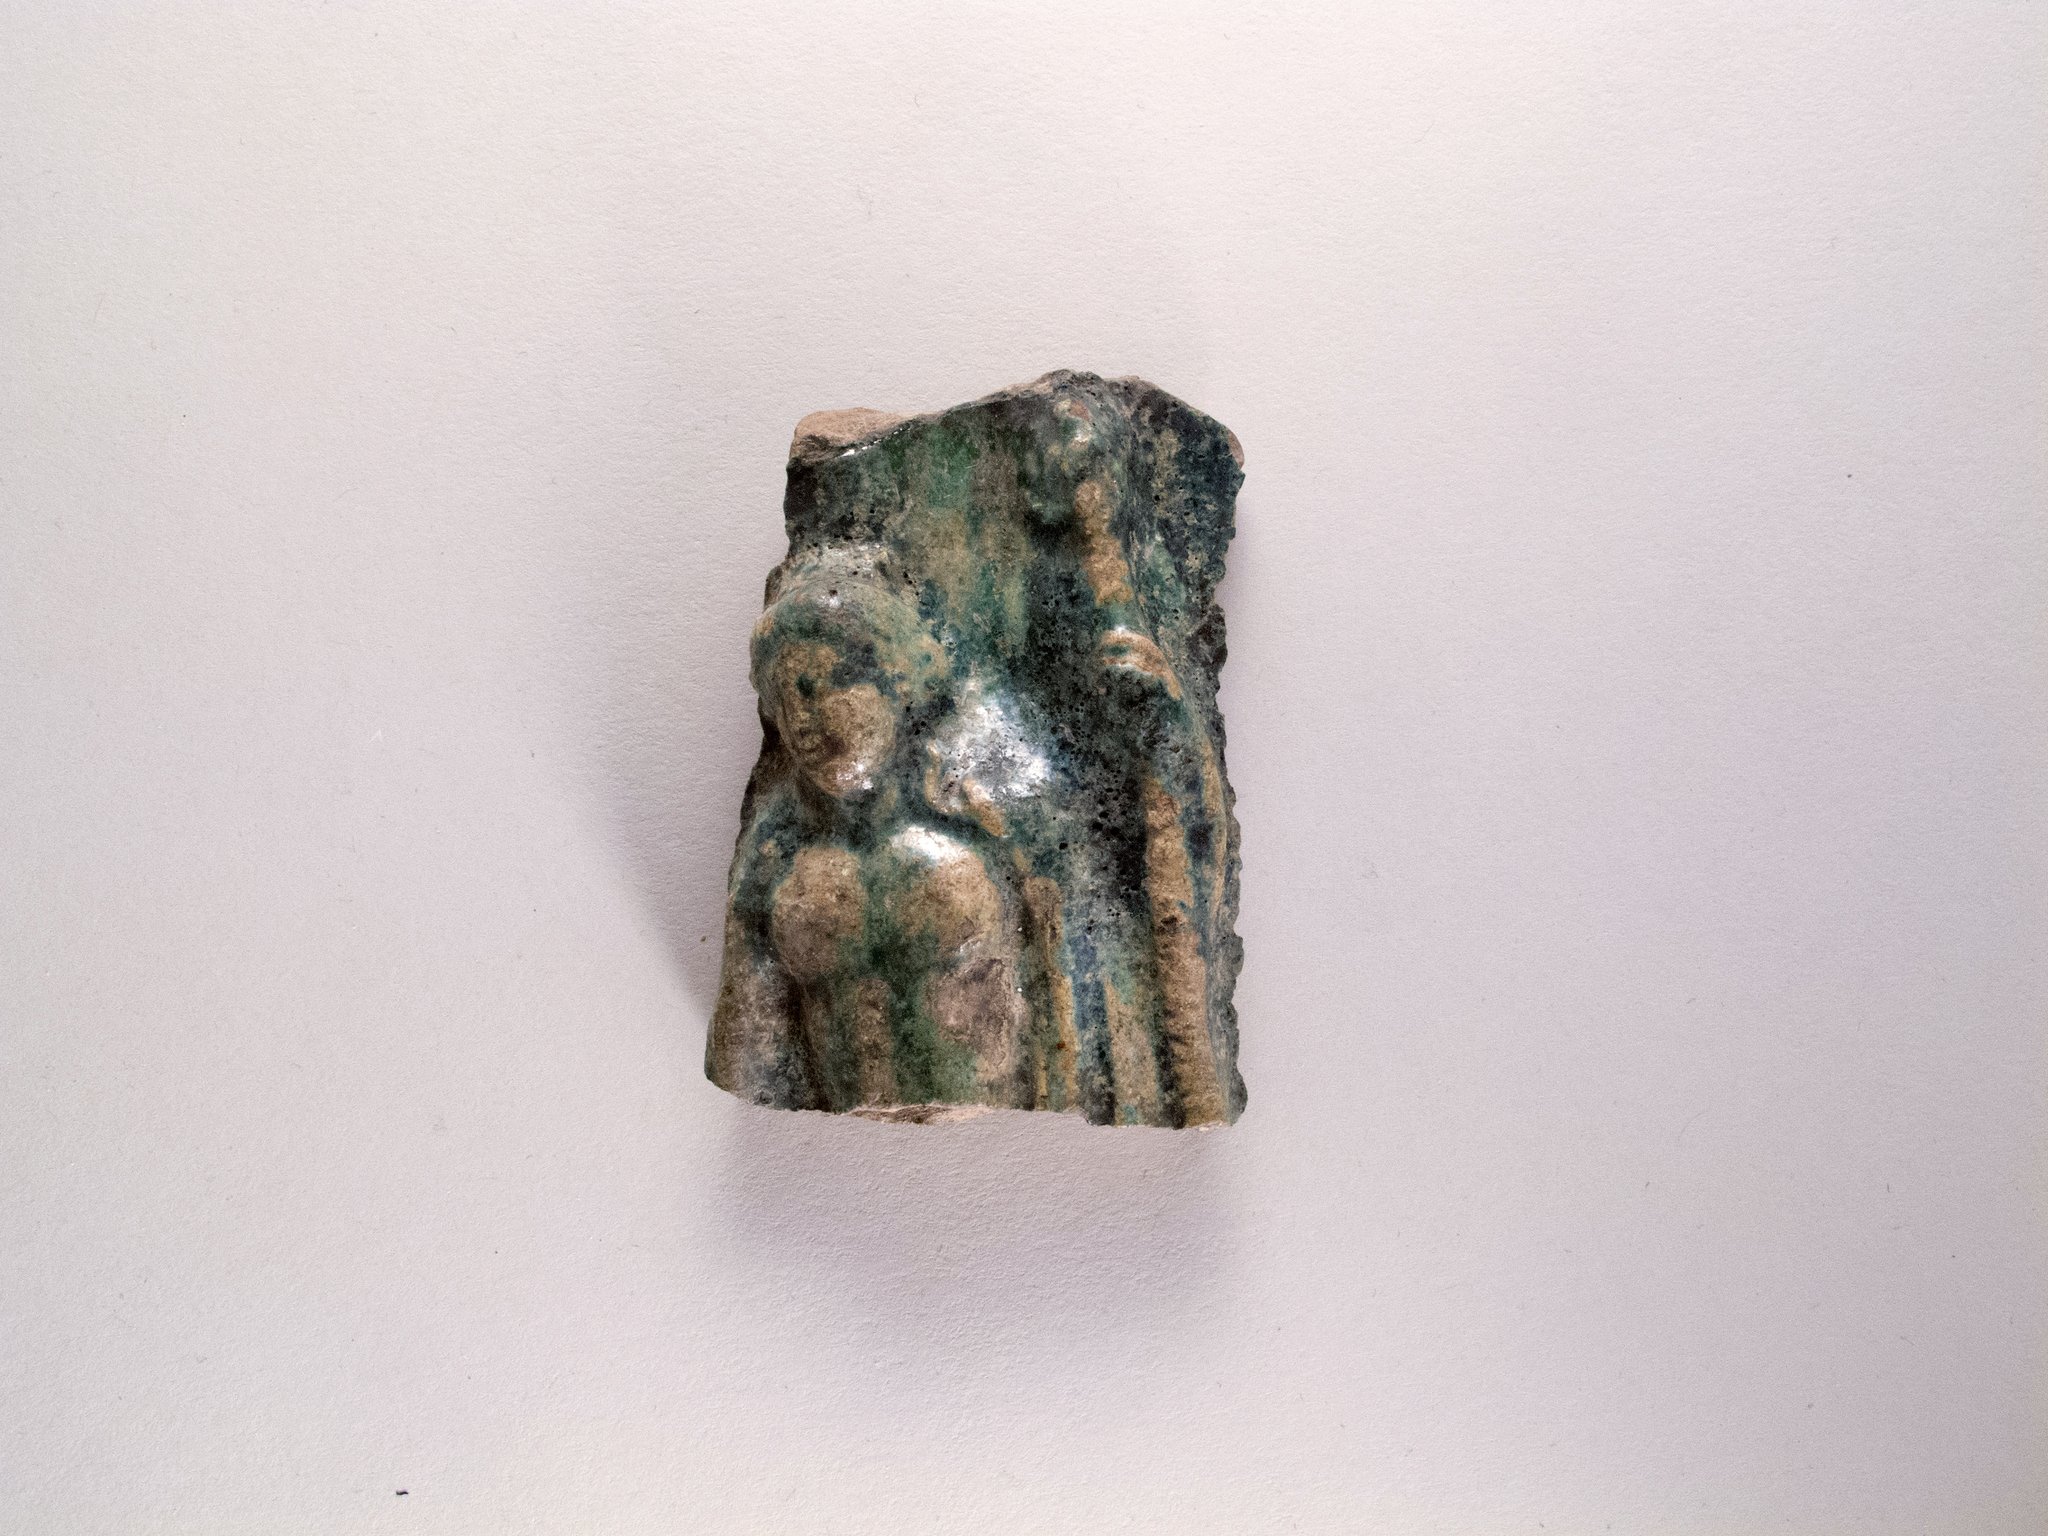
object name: vase fragment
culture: roman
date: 670 BCE-330 CE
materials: terracotta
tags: human figures